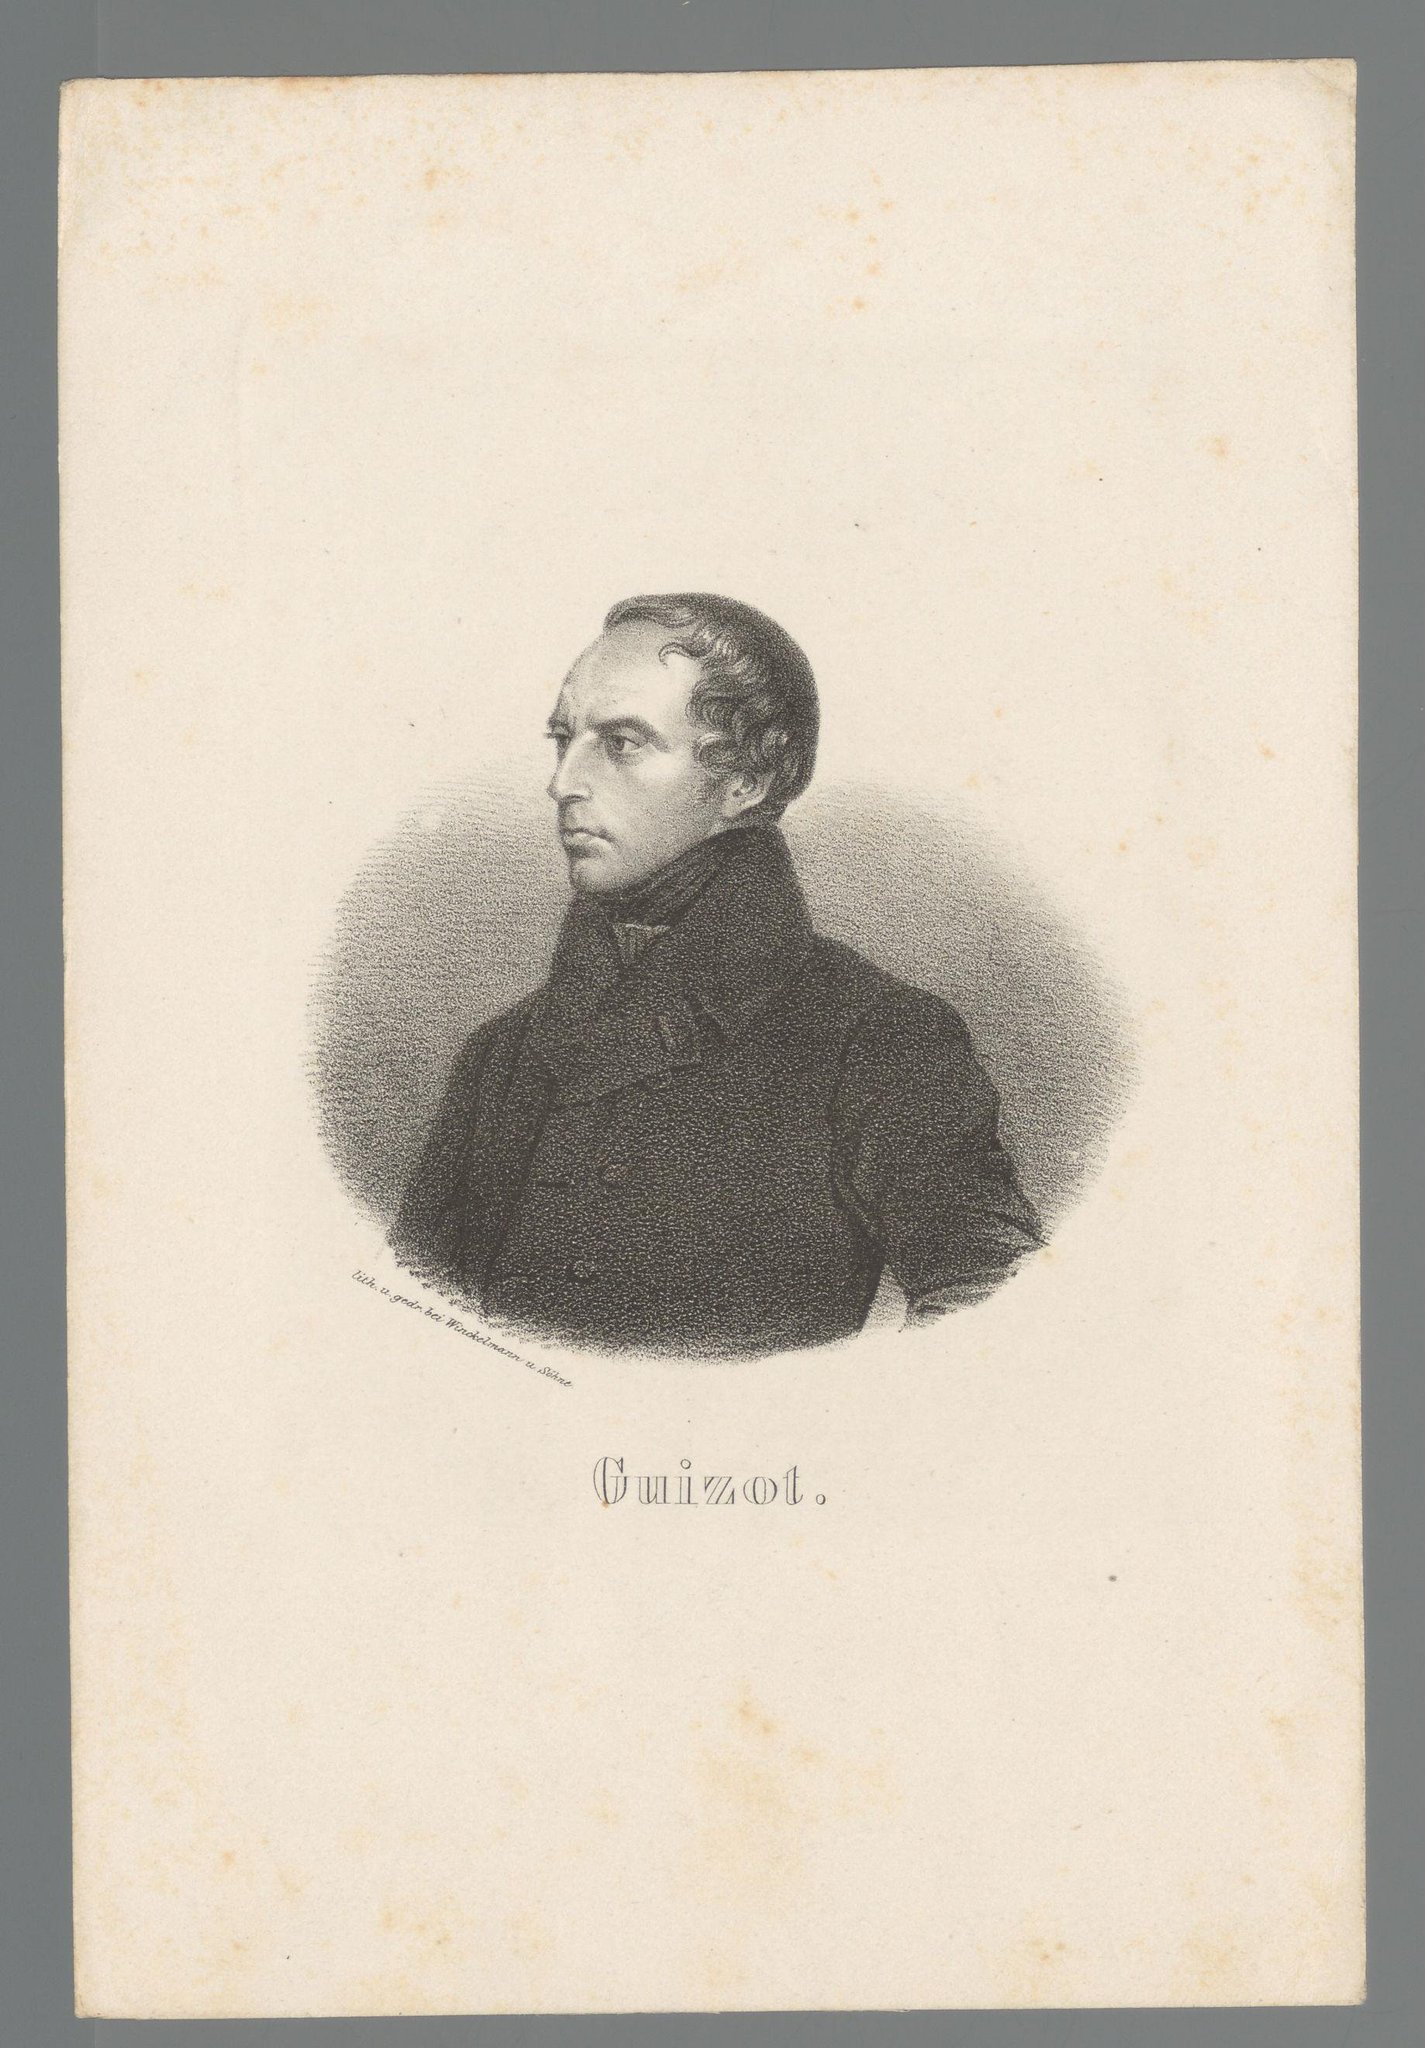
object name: print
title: Guizot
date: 1830-1870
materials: paper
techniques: lithograph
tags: adult man, historical persons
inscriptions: collector's mark: Lugt 2228, inscription